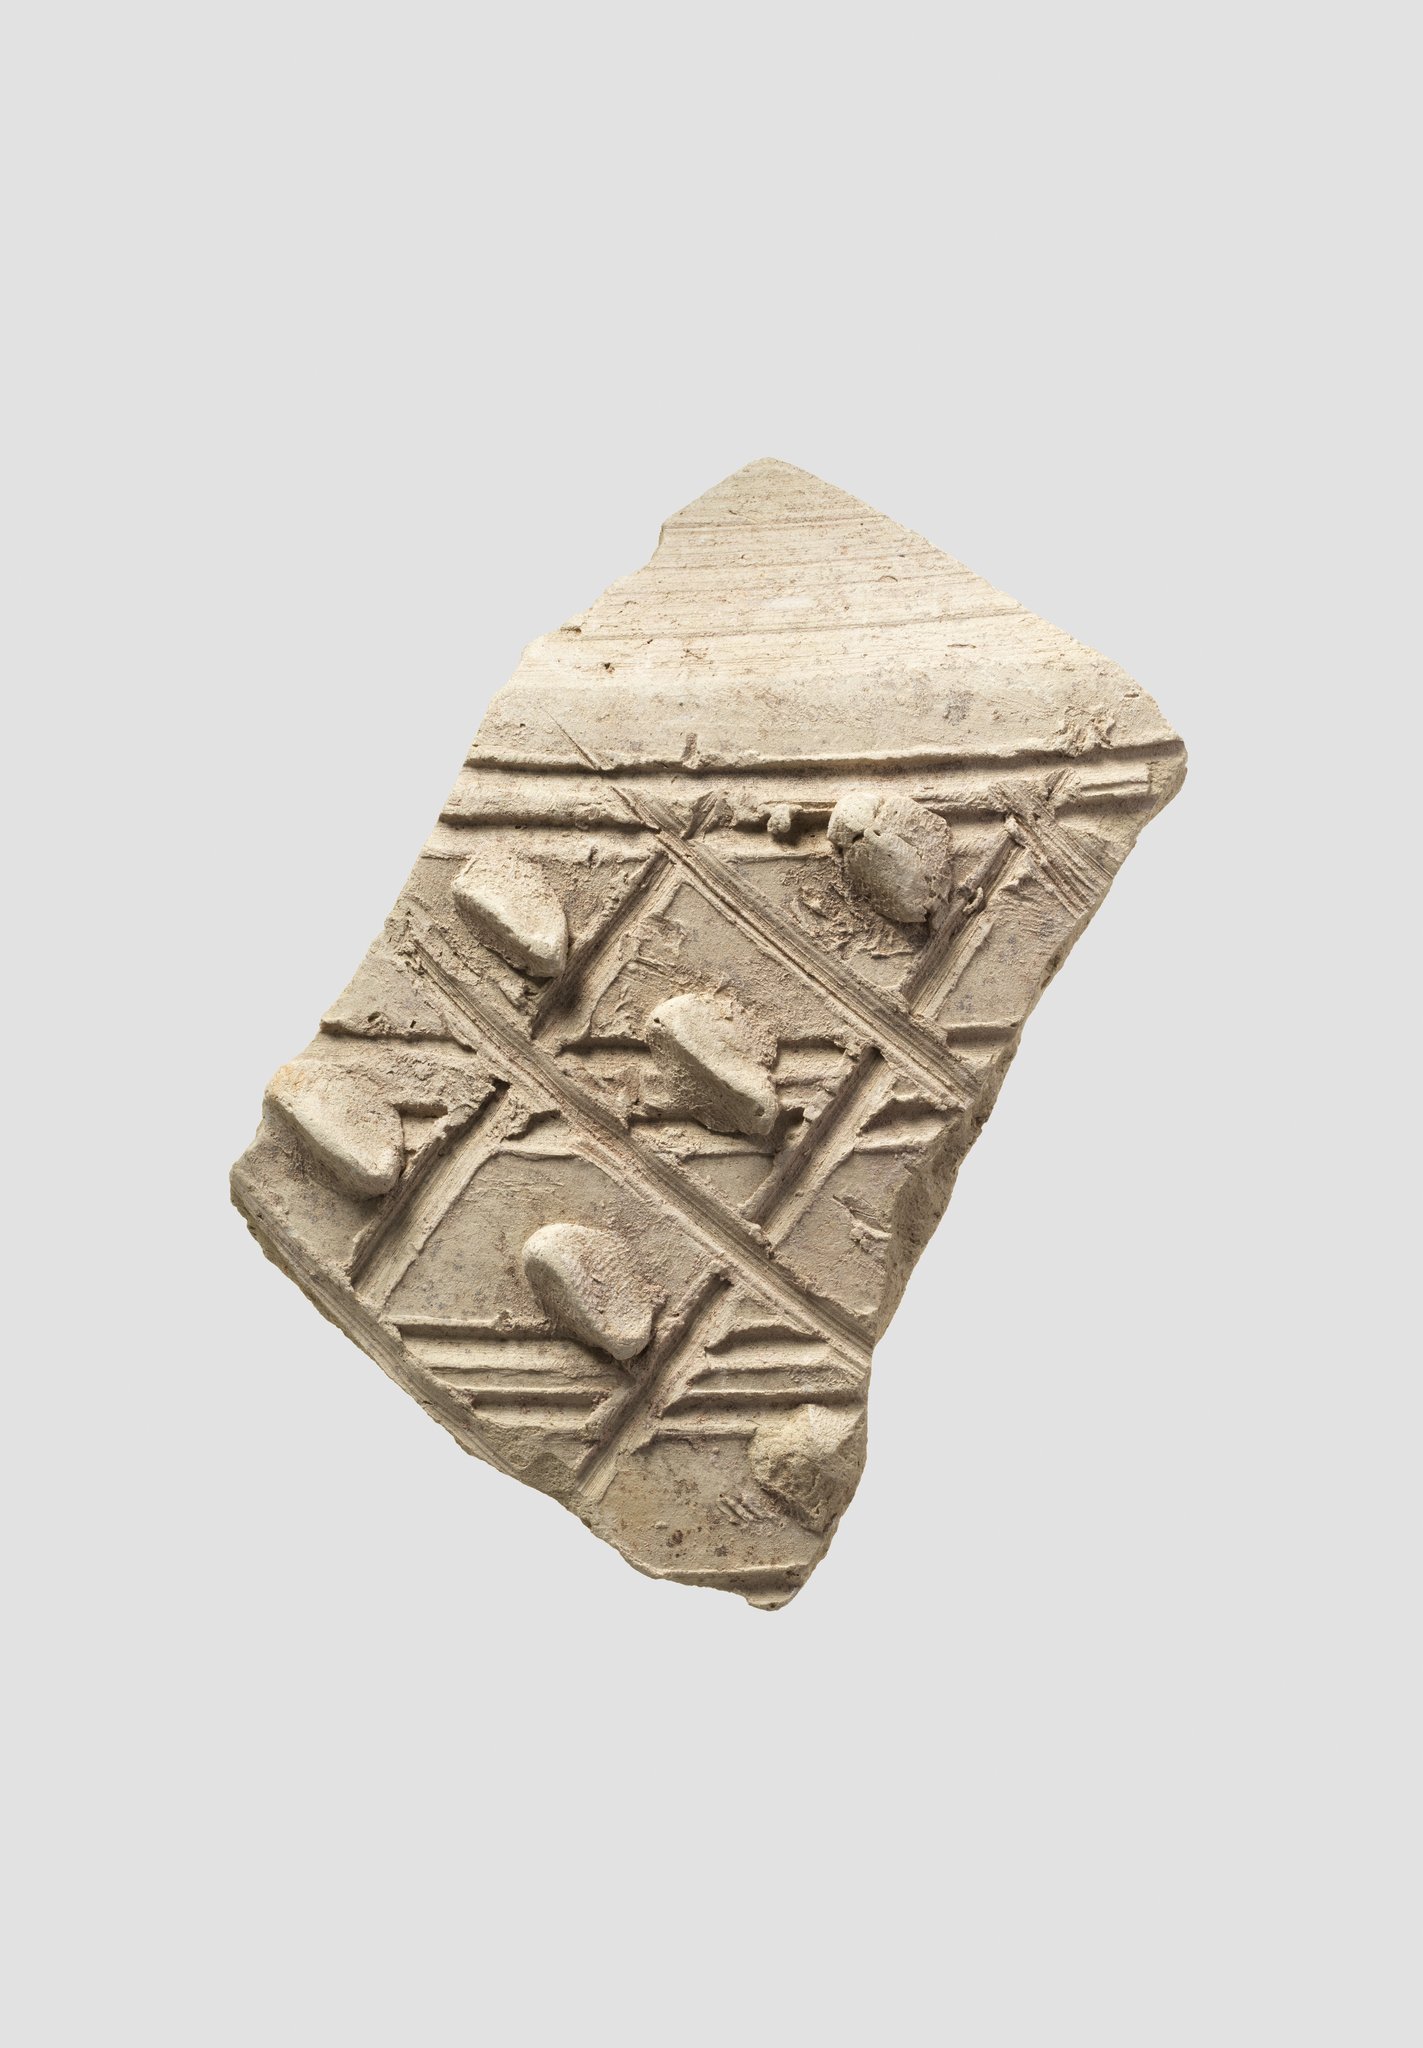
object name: sherd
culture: sasanian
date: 201-700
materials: ceramic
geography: mesopotamia